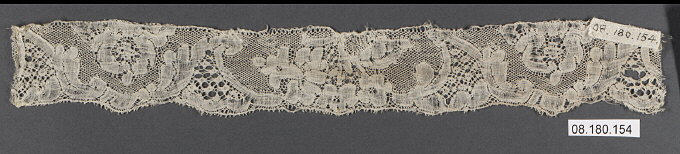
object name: piece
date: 1701-1800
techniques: lace